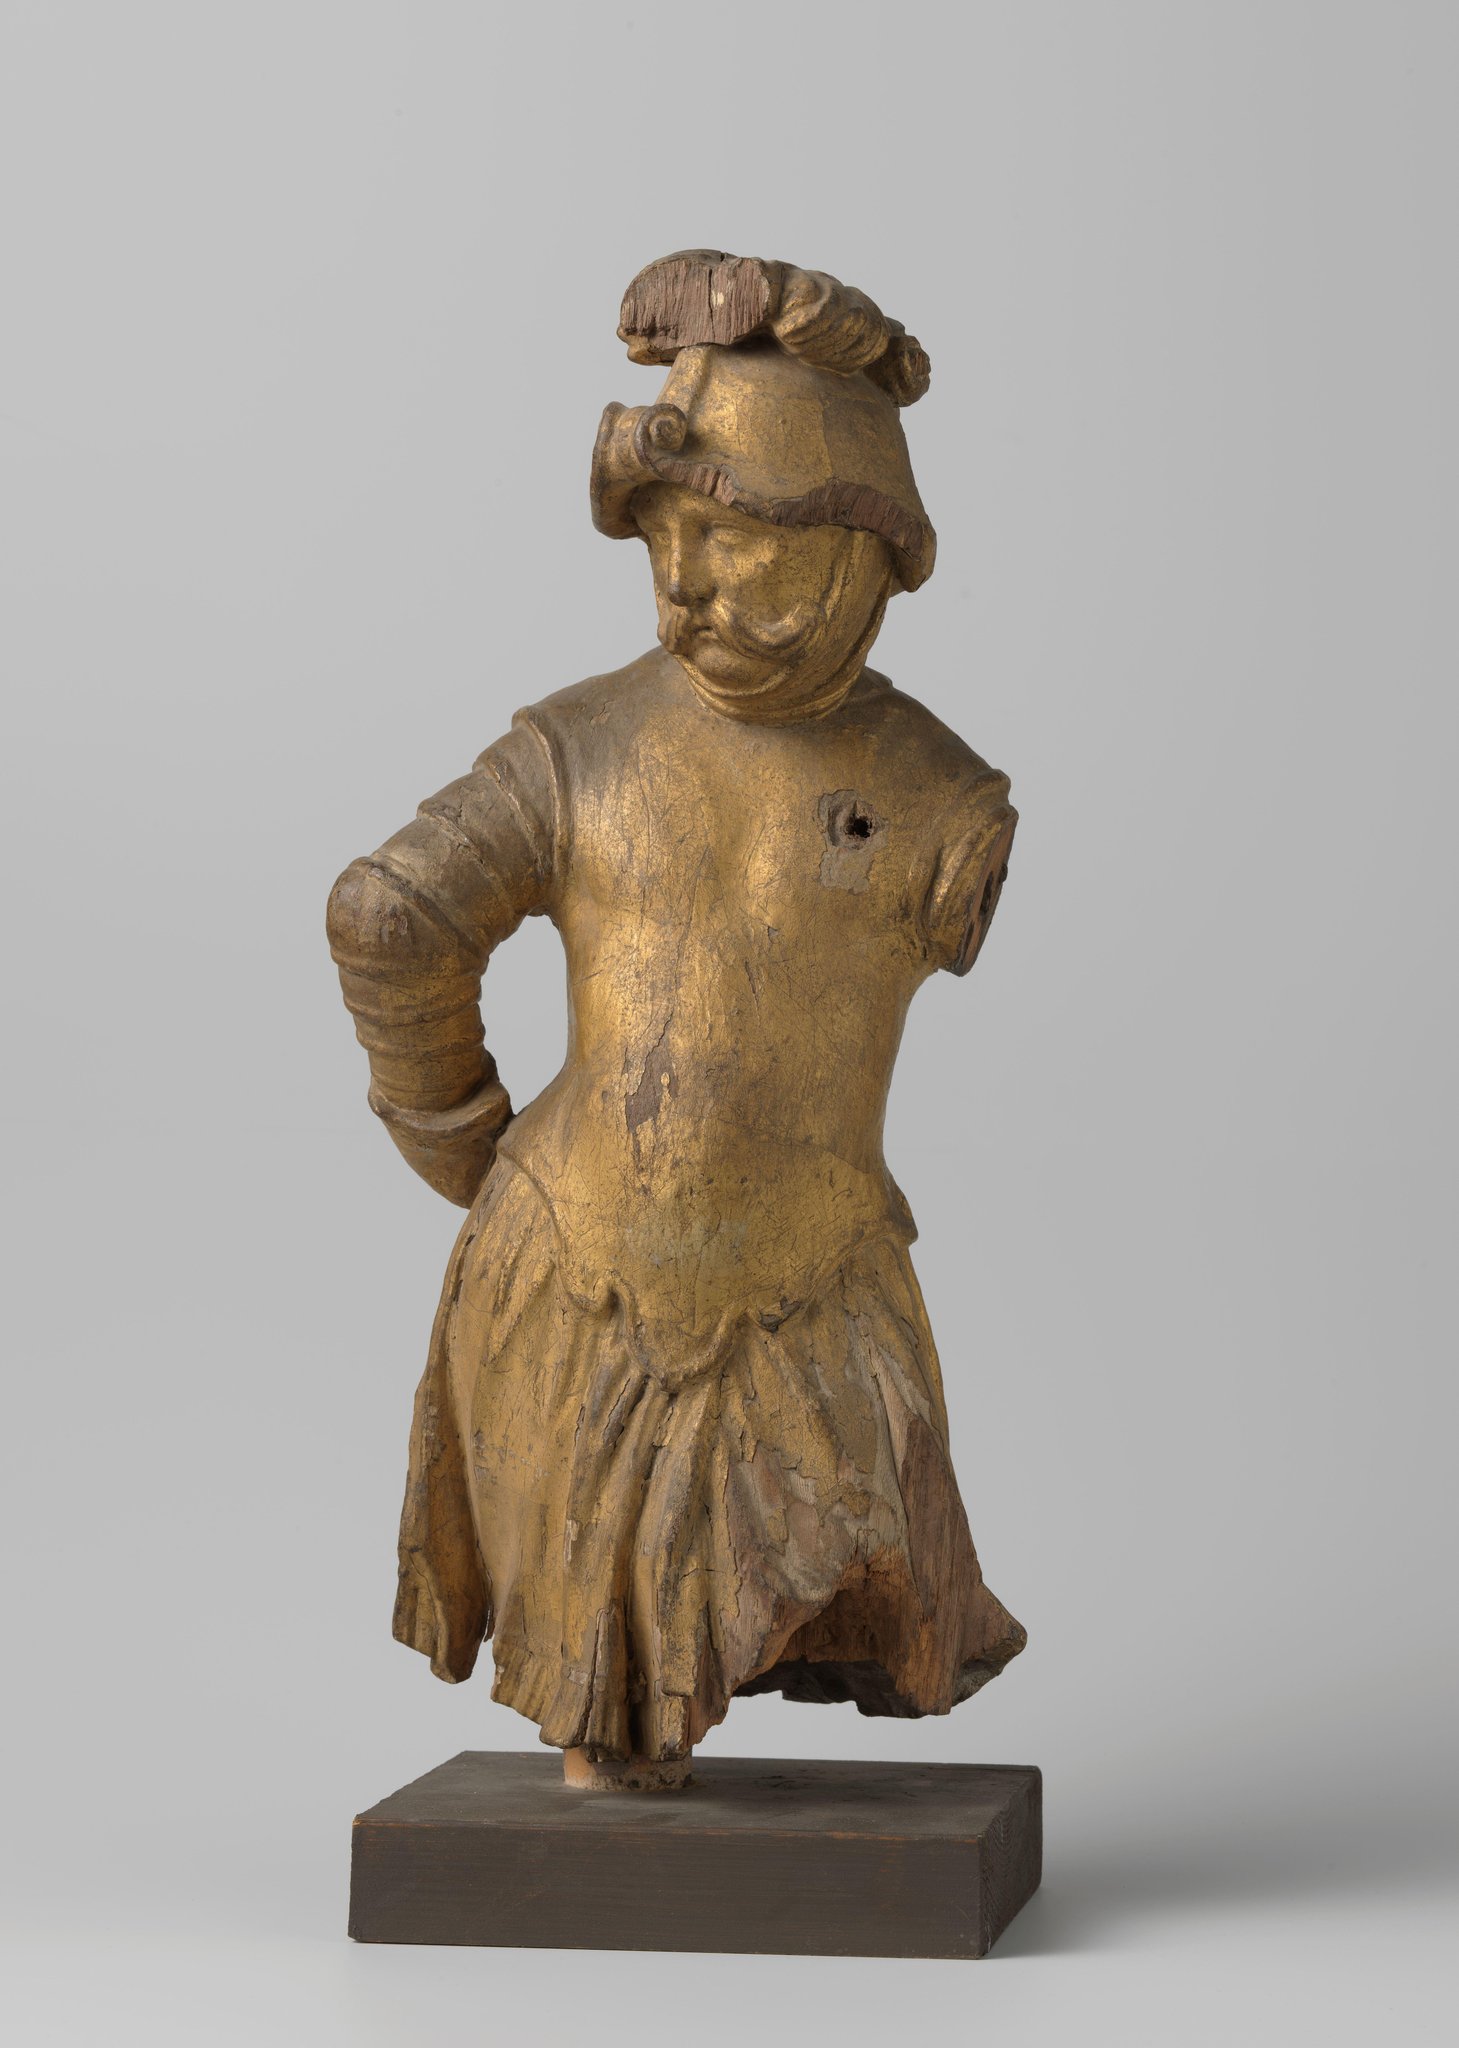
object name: figure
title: Beeld van hout, fragment van het uurwerk in de stadhuistoren van Middelburg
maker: Anonymous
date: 1600-1699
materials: wood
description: Beeld van hout, fragment van het uurwerk in de stadhuistoren van Middelburg, voorstellend een hellebaardier in antiek kostuum. Op sokkel.